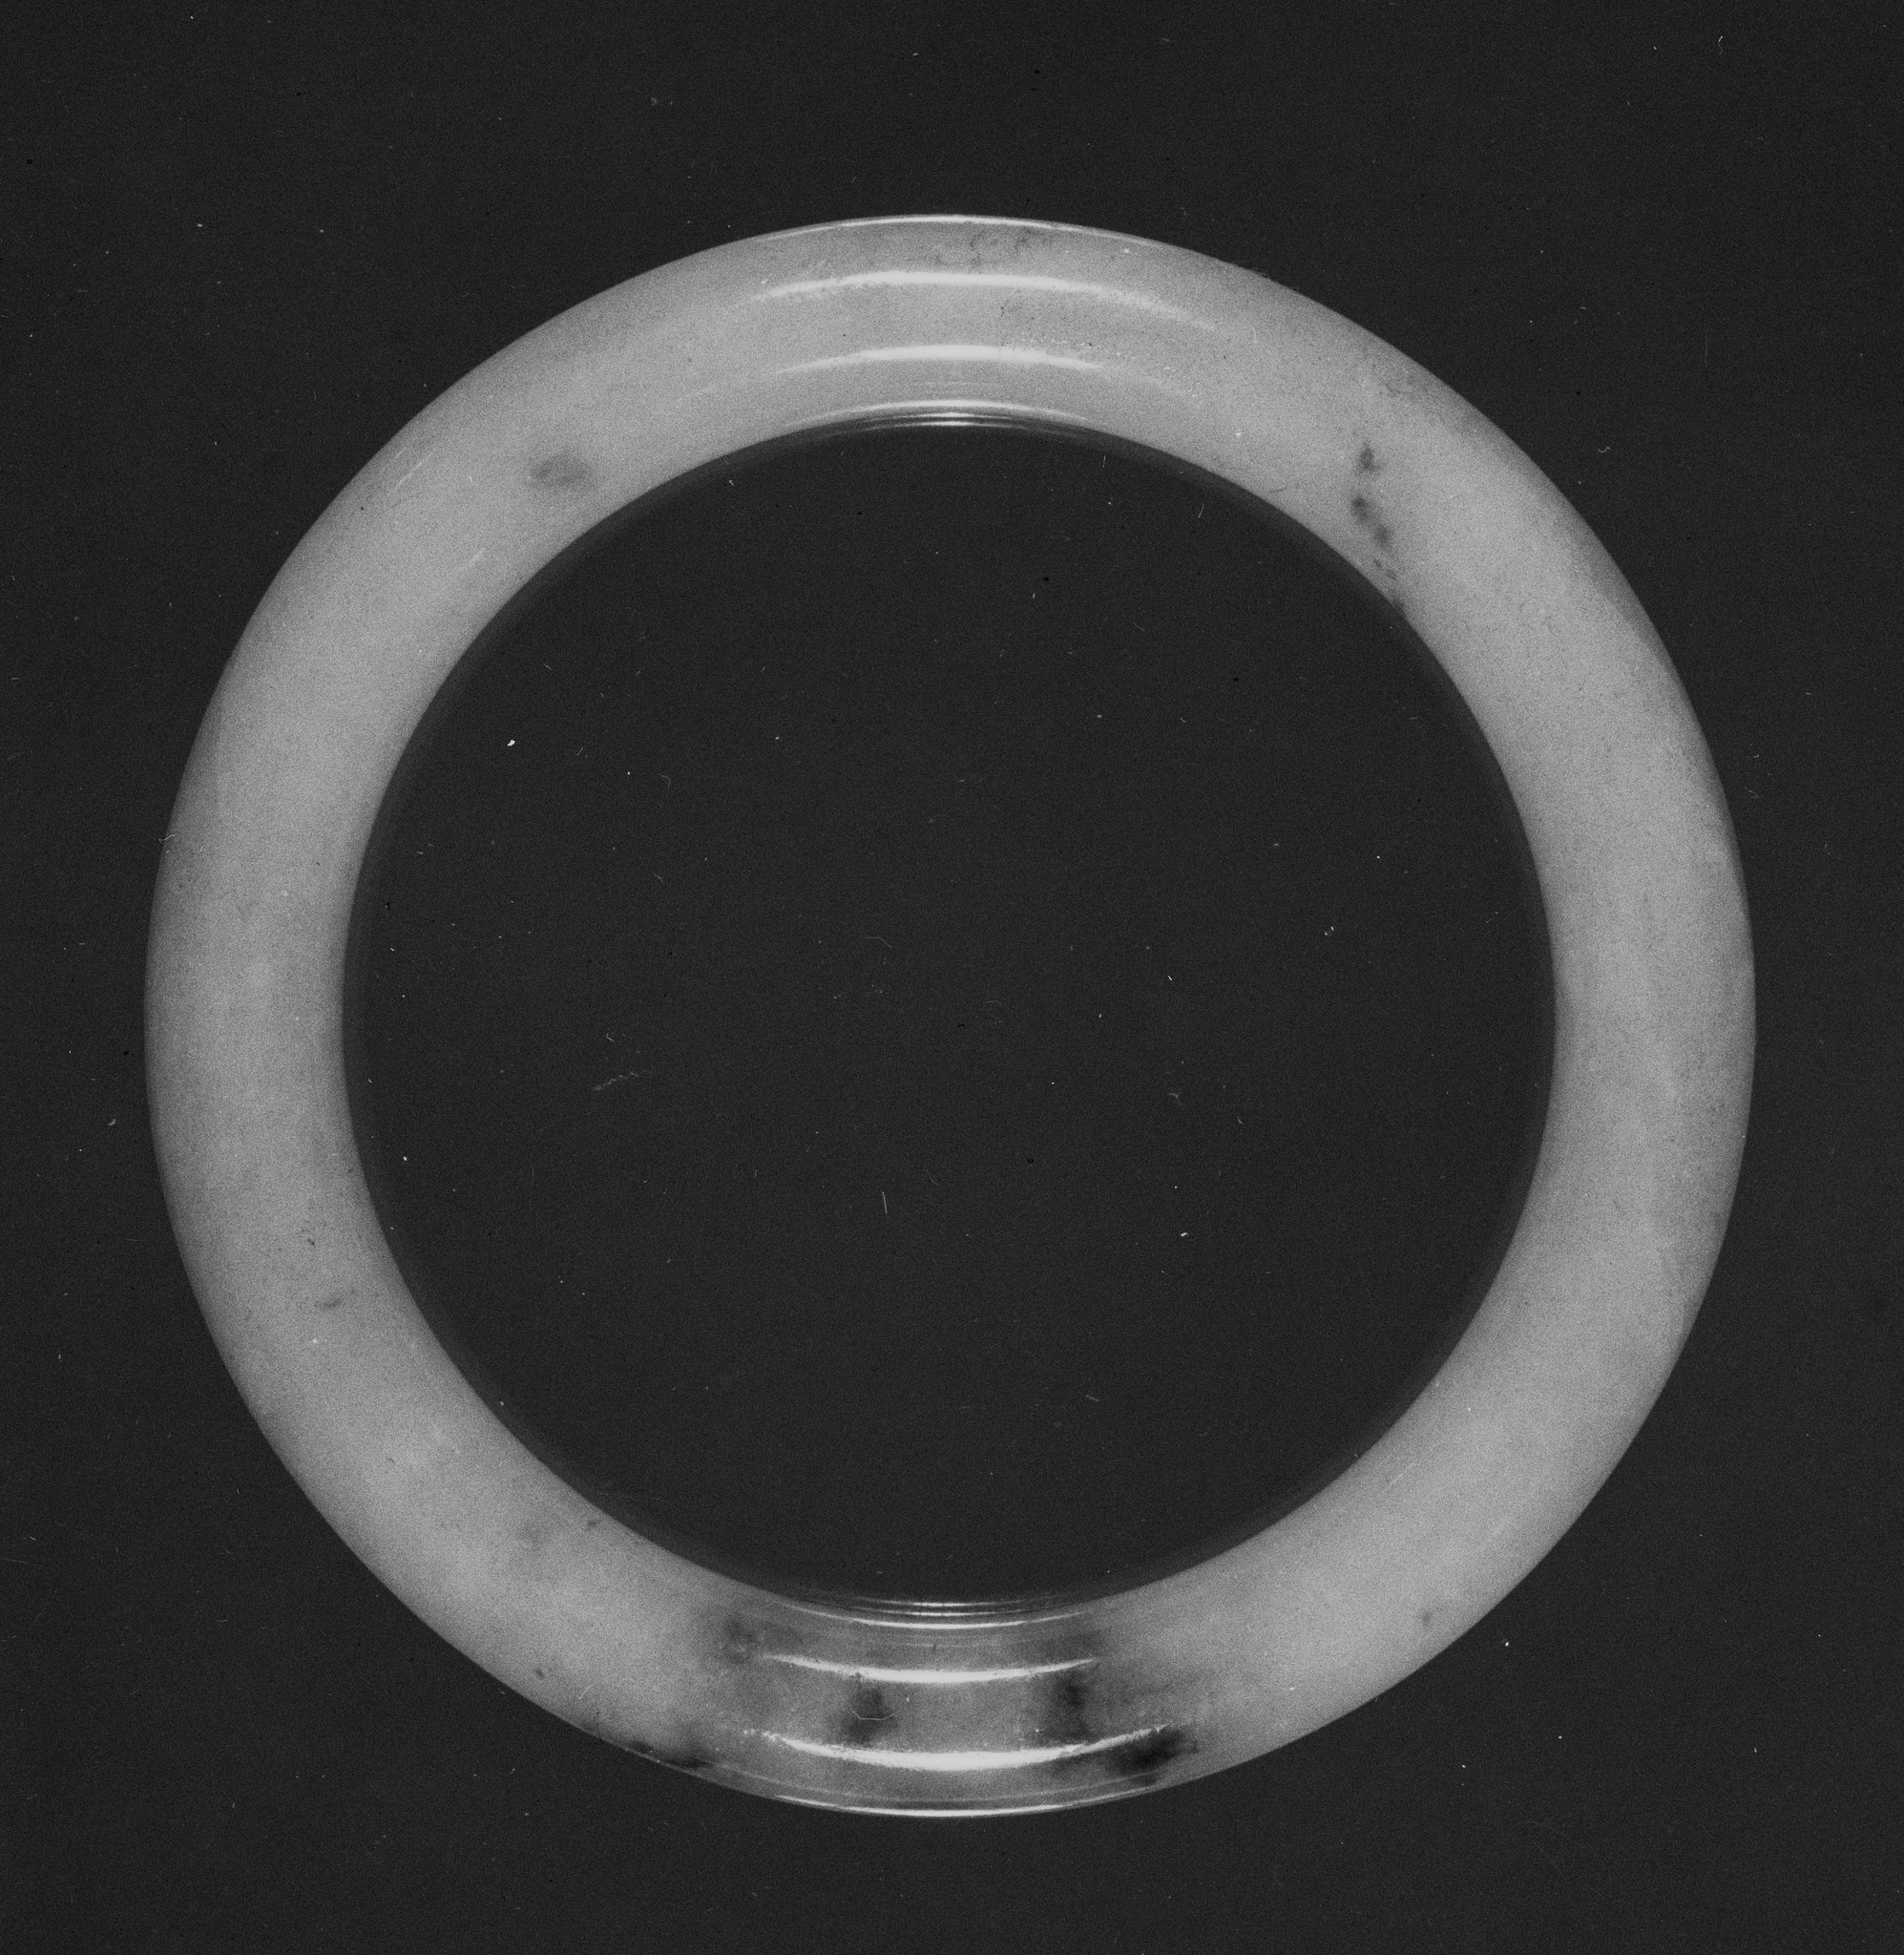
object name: bracelet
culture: chinese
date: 1801-1900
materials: jade